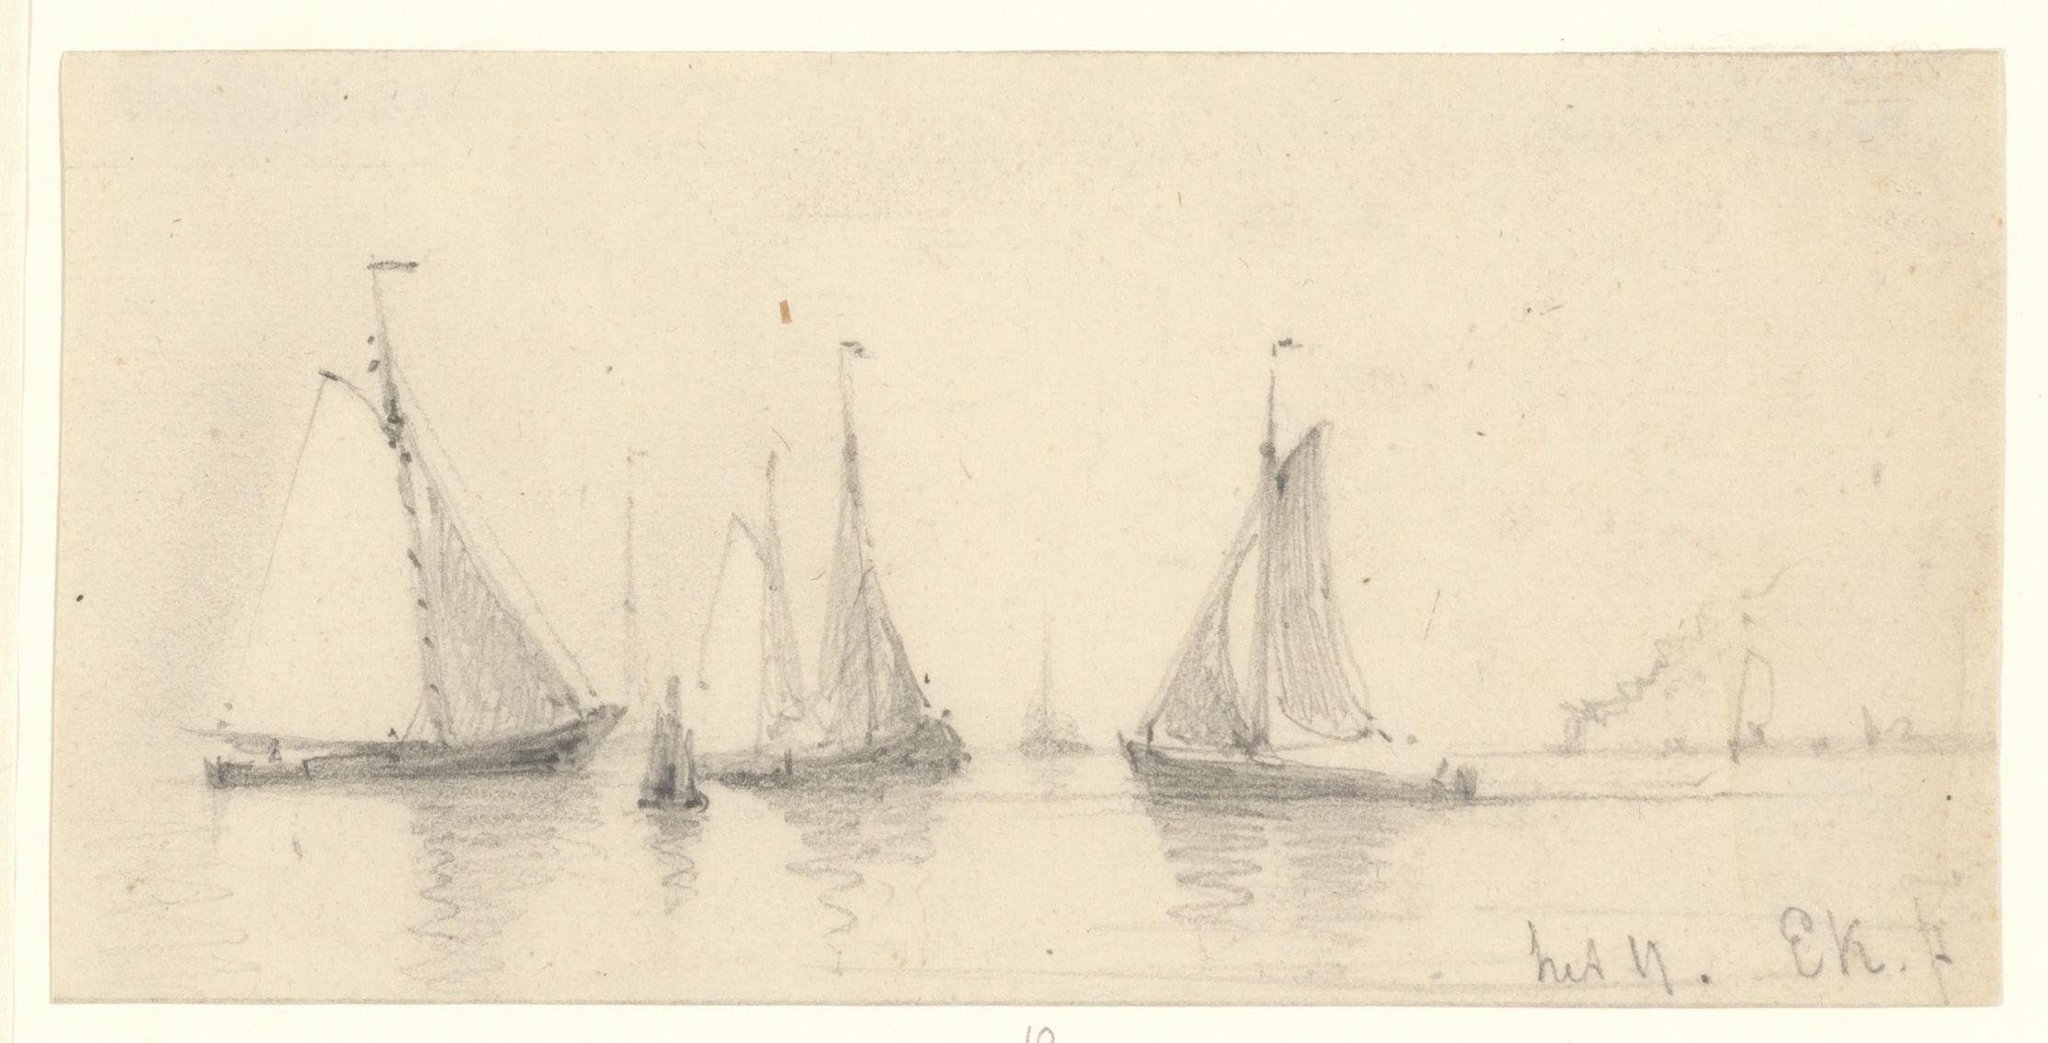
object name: drawing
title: Gezicht op het IJ met schepen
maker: everhardus koster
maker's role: draughtsman, painter, print maker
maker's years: 1817-1892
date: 1827-1892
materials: paper, pencil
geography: amsterdam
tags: sailing-ship, sailing-boat, river, amsterdam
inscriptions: collector's mark: Lugt 800a, inscription: ‘het IJ.’, signature: ‘EK.’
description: Tekening binnen de Atlas Van Eck ingedeeld op wijknummer 2.